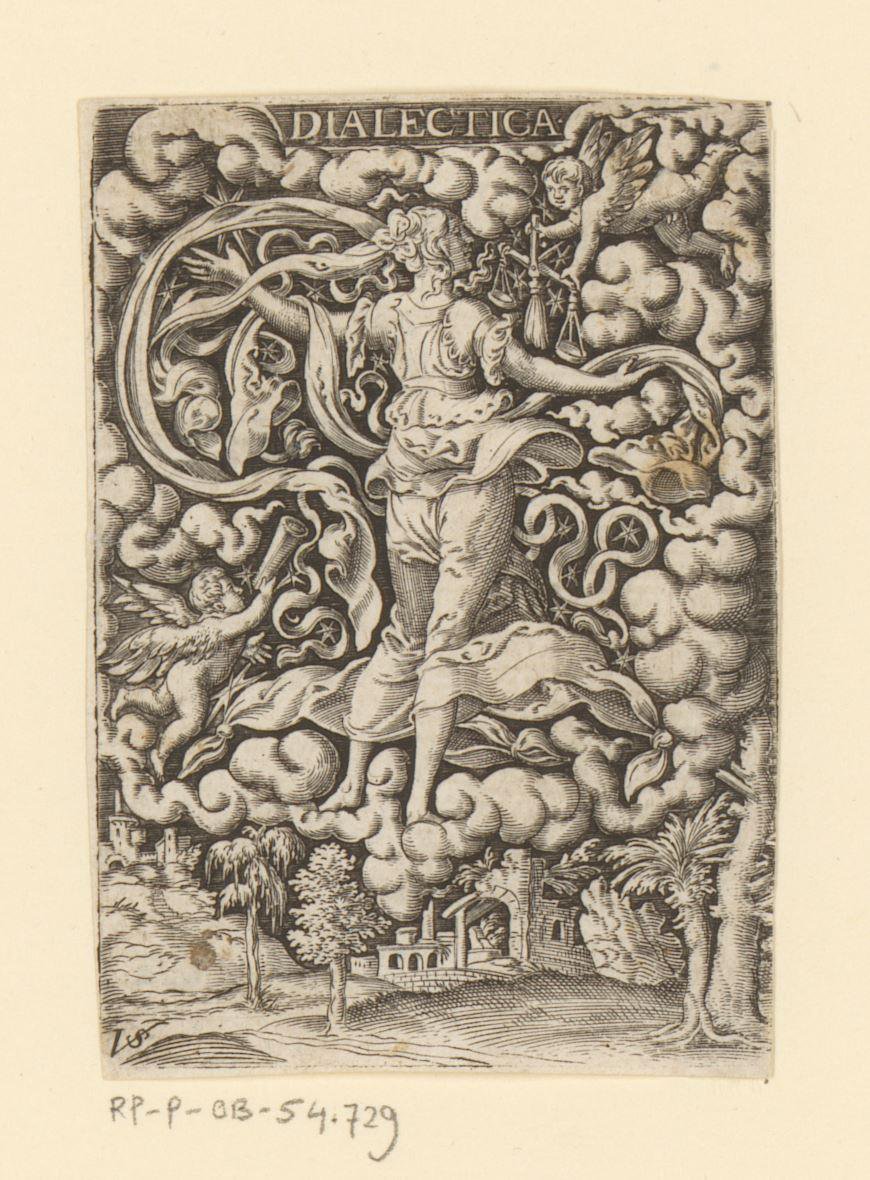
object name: print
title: Dialectiek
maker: virgilius solis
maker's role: draughtsman, print maker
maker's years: 1514-1562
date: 1524-1562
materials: paper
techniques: engraving, etching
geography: nuremberg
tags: city-view, and landscape with man-made constructions, clouds, 'dialectica' (~ trivium); 'dialettica' (ripa)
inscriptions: number: ‘59’, collector's mark: Lugt 2228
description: Prent maakt deel uit van een serie van zeven prenten met personificaties van de vrije kunsten omringd door wolken.